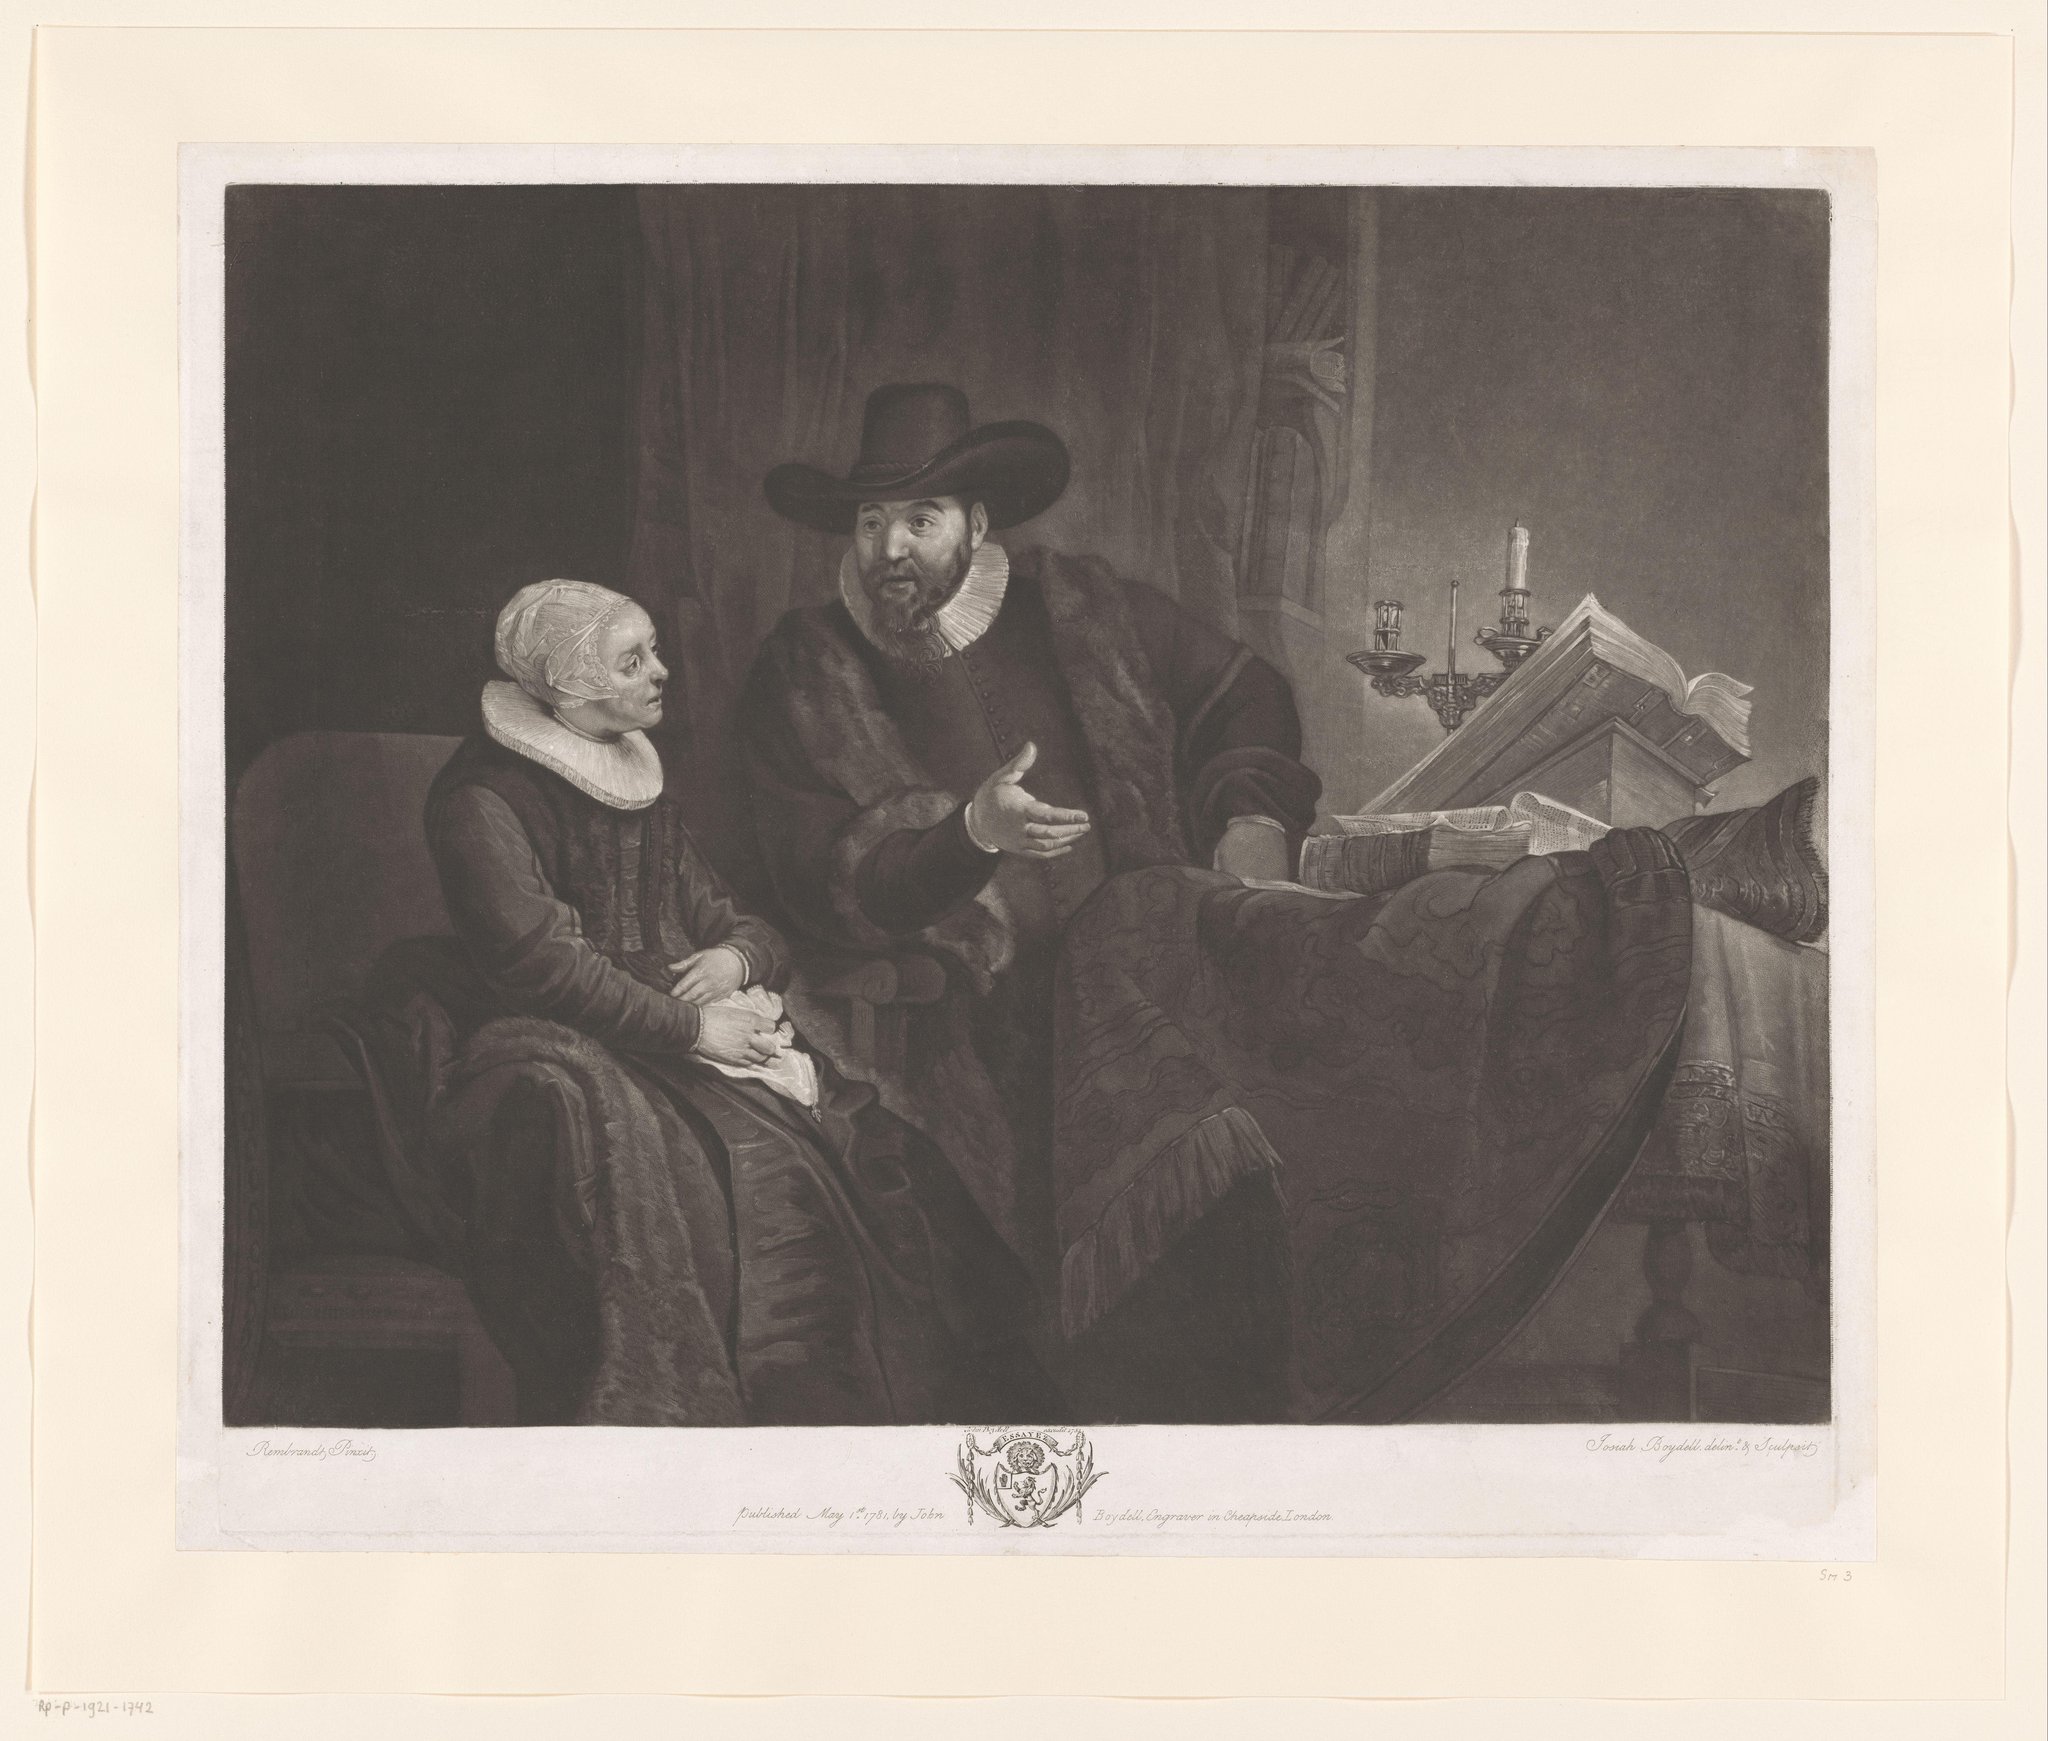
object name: print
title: Portret van Cornelis Claesz. Anslo en Aaltje Schouten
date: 1705-1781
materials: paper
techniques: etching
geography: london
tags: functionaries and dignitaries (with name) ~ protestant churches, historical persons - bb - woman, historical persons, speaking, the bible as a book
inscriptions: date